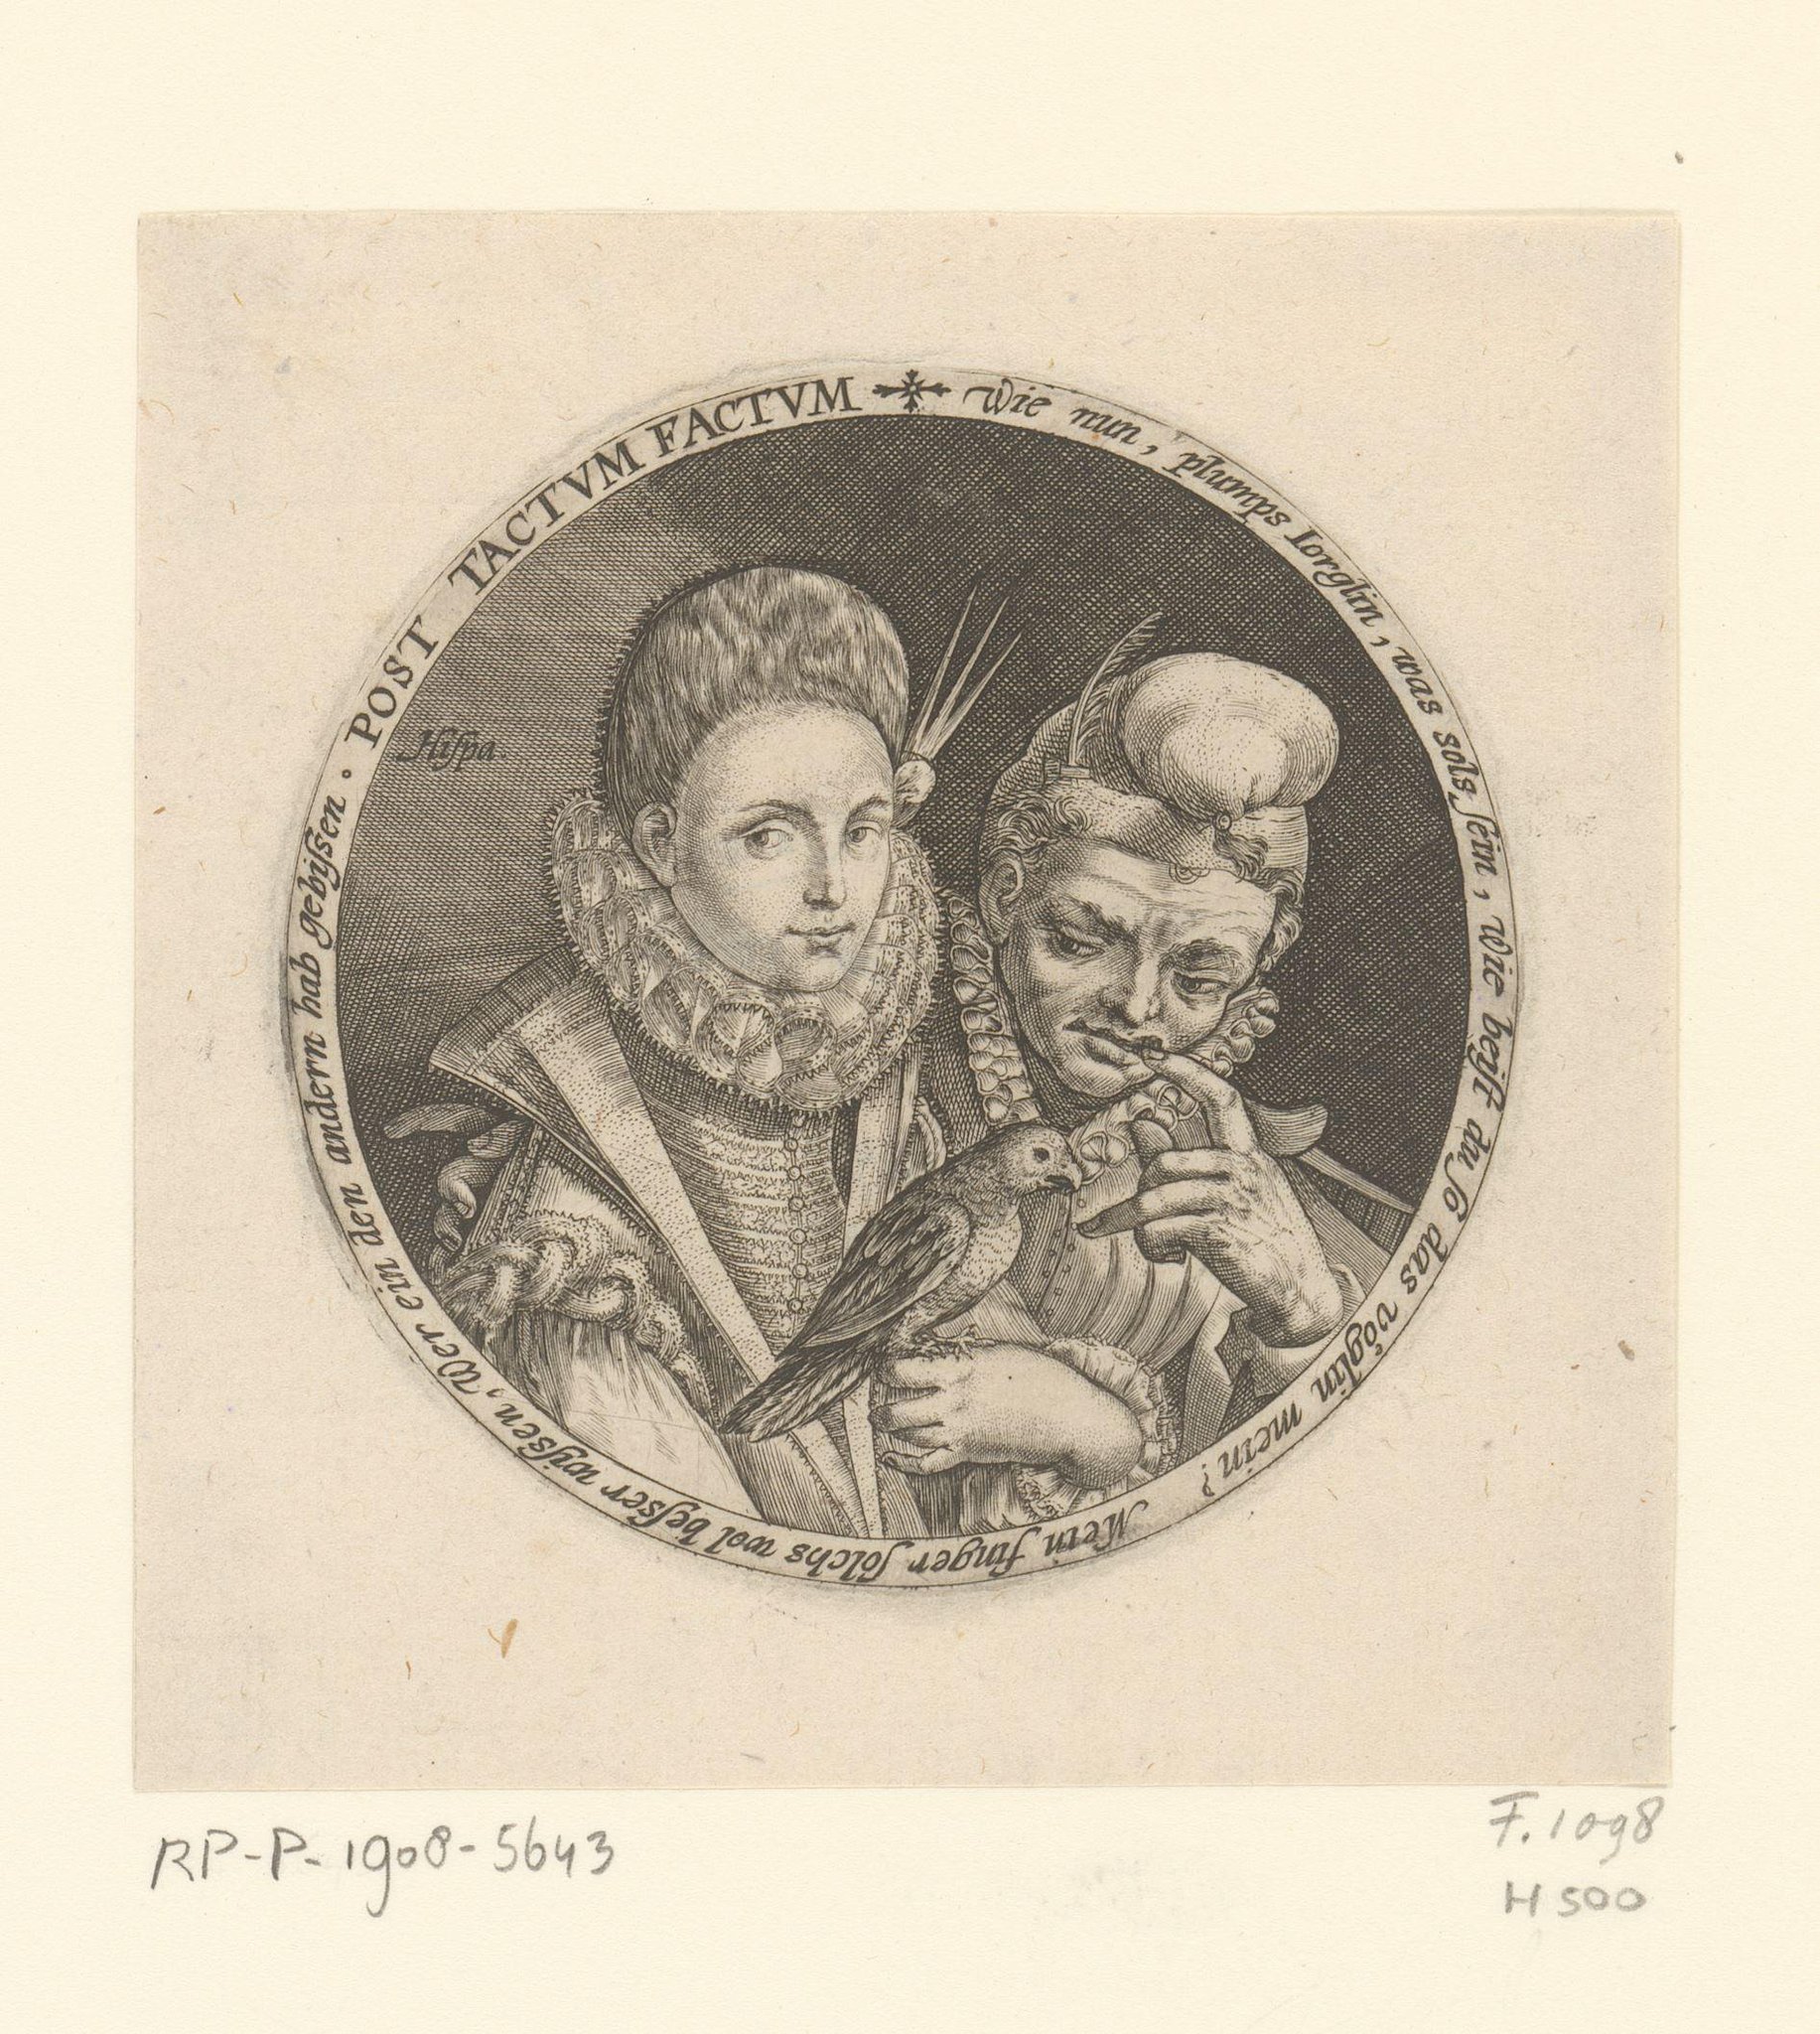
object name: print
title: Quinque Sensuum Figurae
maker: crispijn van de passe (i)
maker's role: draughtsman, print maker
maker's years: 1564-1637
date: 1589-1611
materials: paper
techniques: engraving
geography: cologne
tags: feeling (one of the five senses)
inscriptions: collector's mark: Lugt 2228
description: De personificatie van de tastzin, gekleed volgens de Spaanse mode. Op haar hand zit een papegaai. Ze wordt vergezeld door een man die zijn vinger in zijn mond stopt omdat hij zojuist door de vogel gebeten is. De omlijsting heeft een randschrift in het Duits en een motto in het Latijn dat verwijst naar het bedrijven van de liefde.